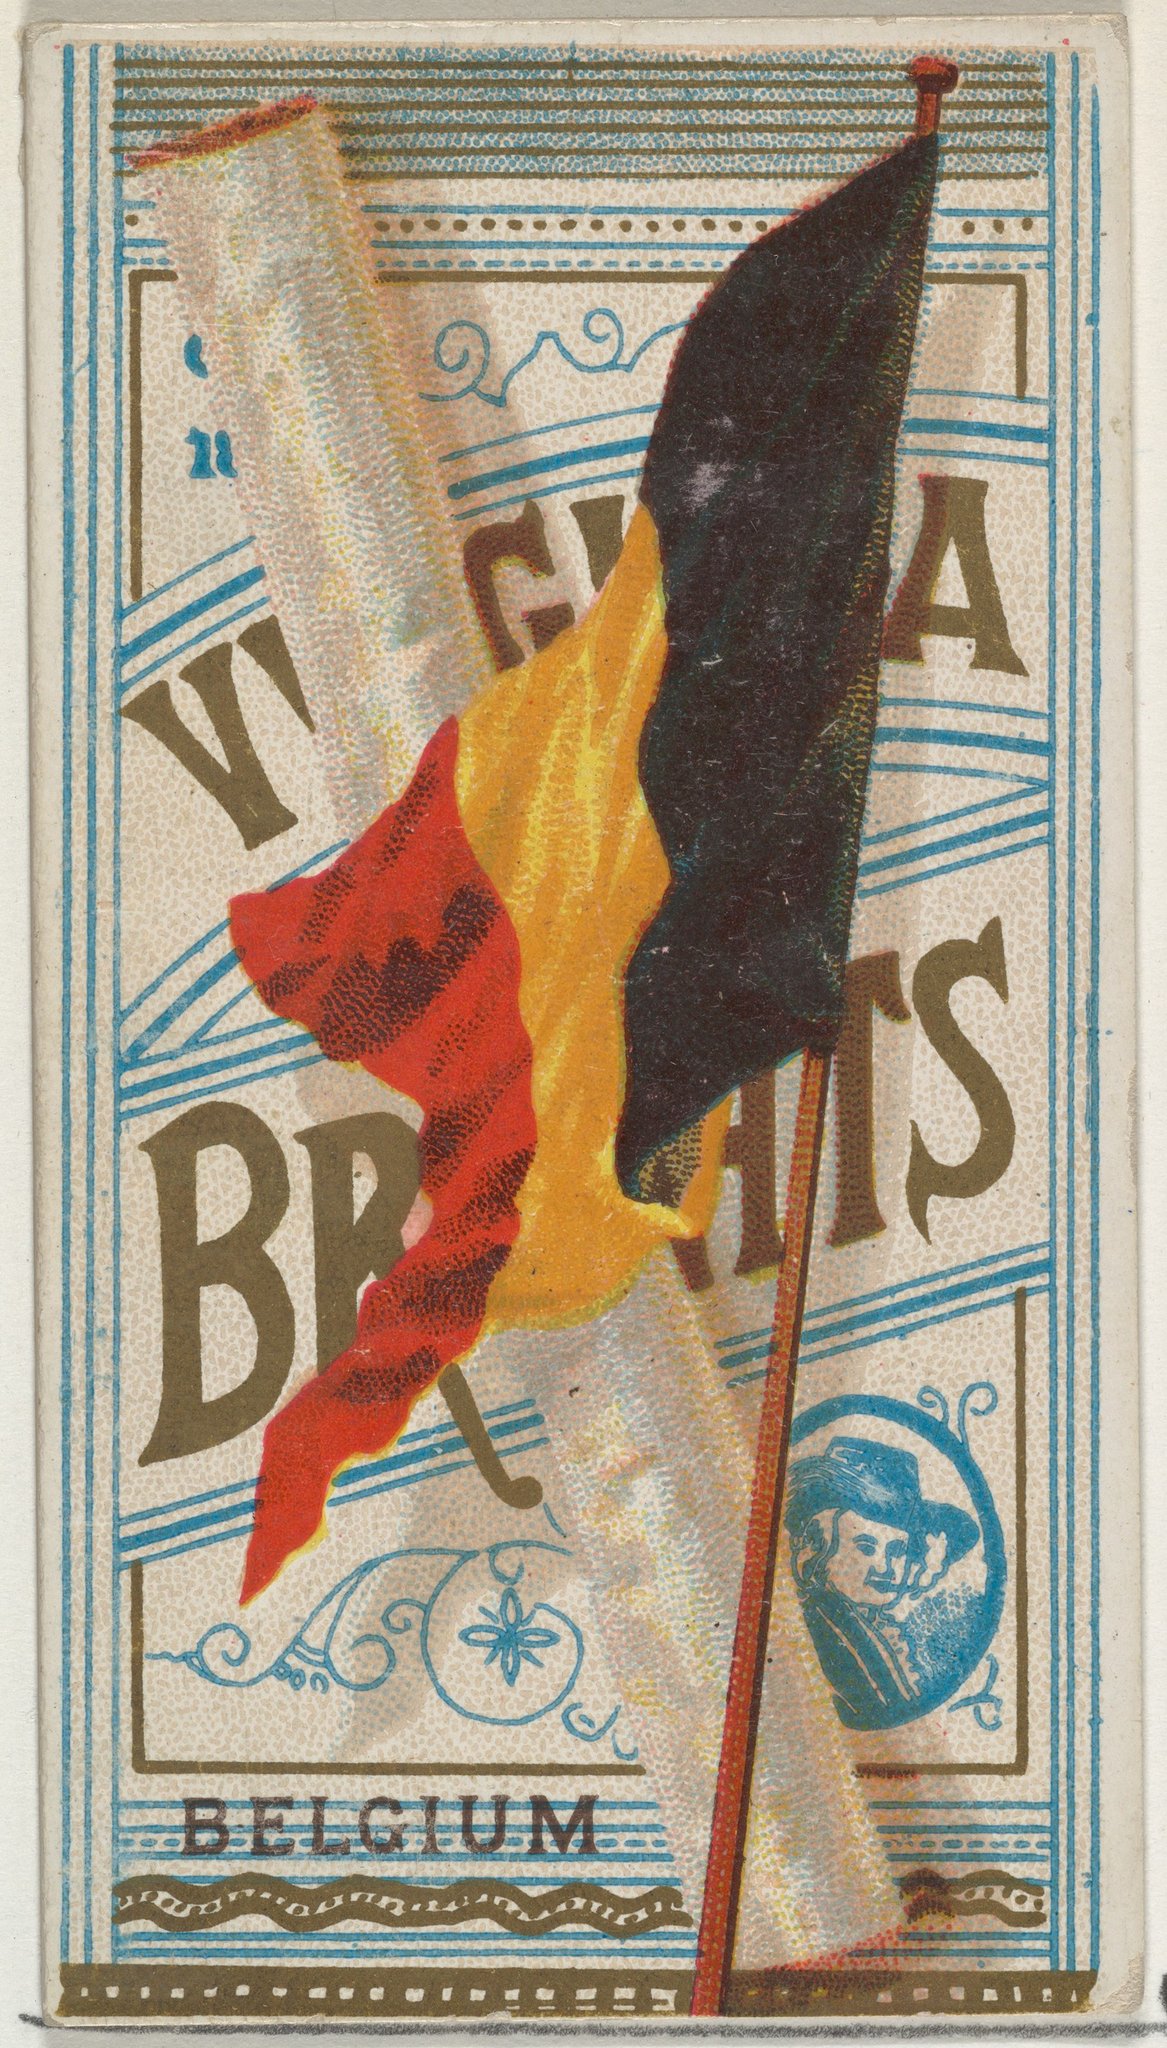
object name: print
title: Belgium, from Flags of All Nations, Series 1 (N9) for Allen & Ginter Cigarettes Brands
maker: allen & ginter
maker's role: publisher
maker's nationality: american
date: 1887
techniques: color lithograph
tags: flags